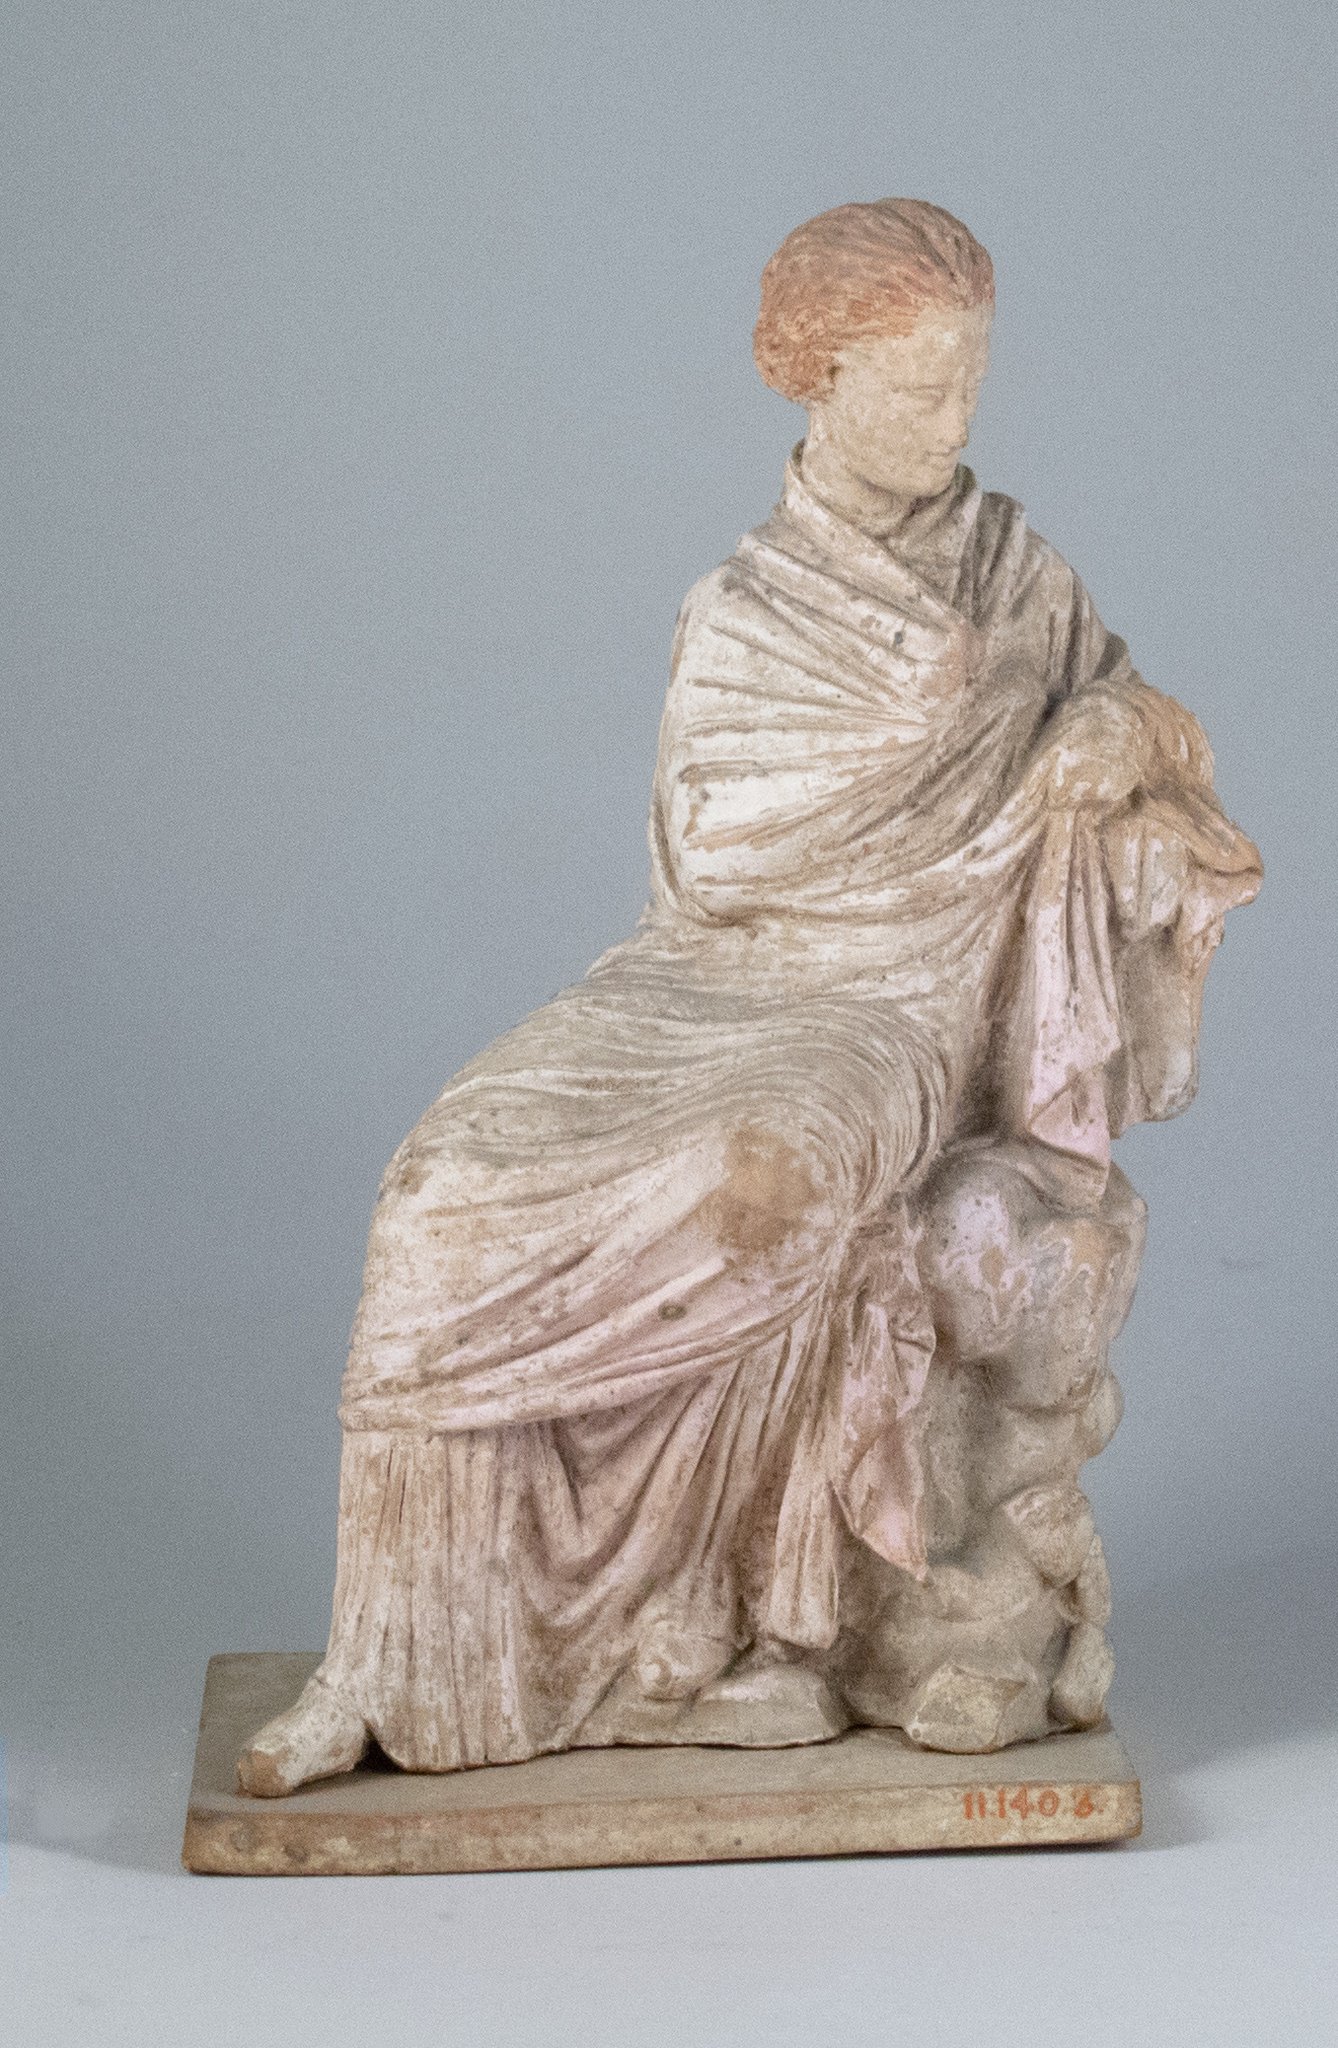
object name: statuette of a girl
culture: greek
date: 7000-30 BCE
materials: terracotta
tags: girls